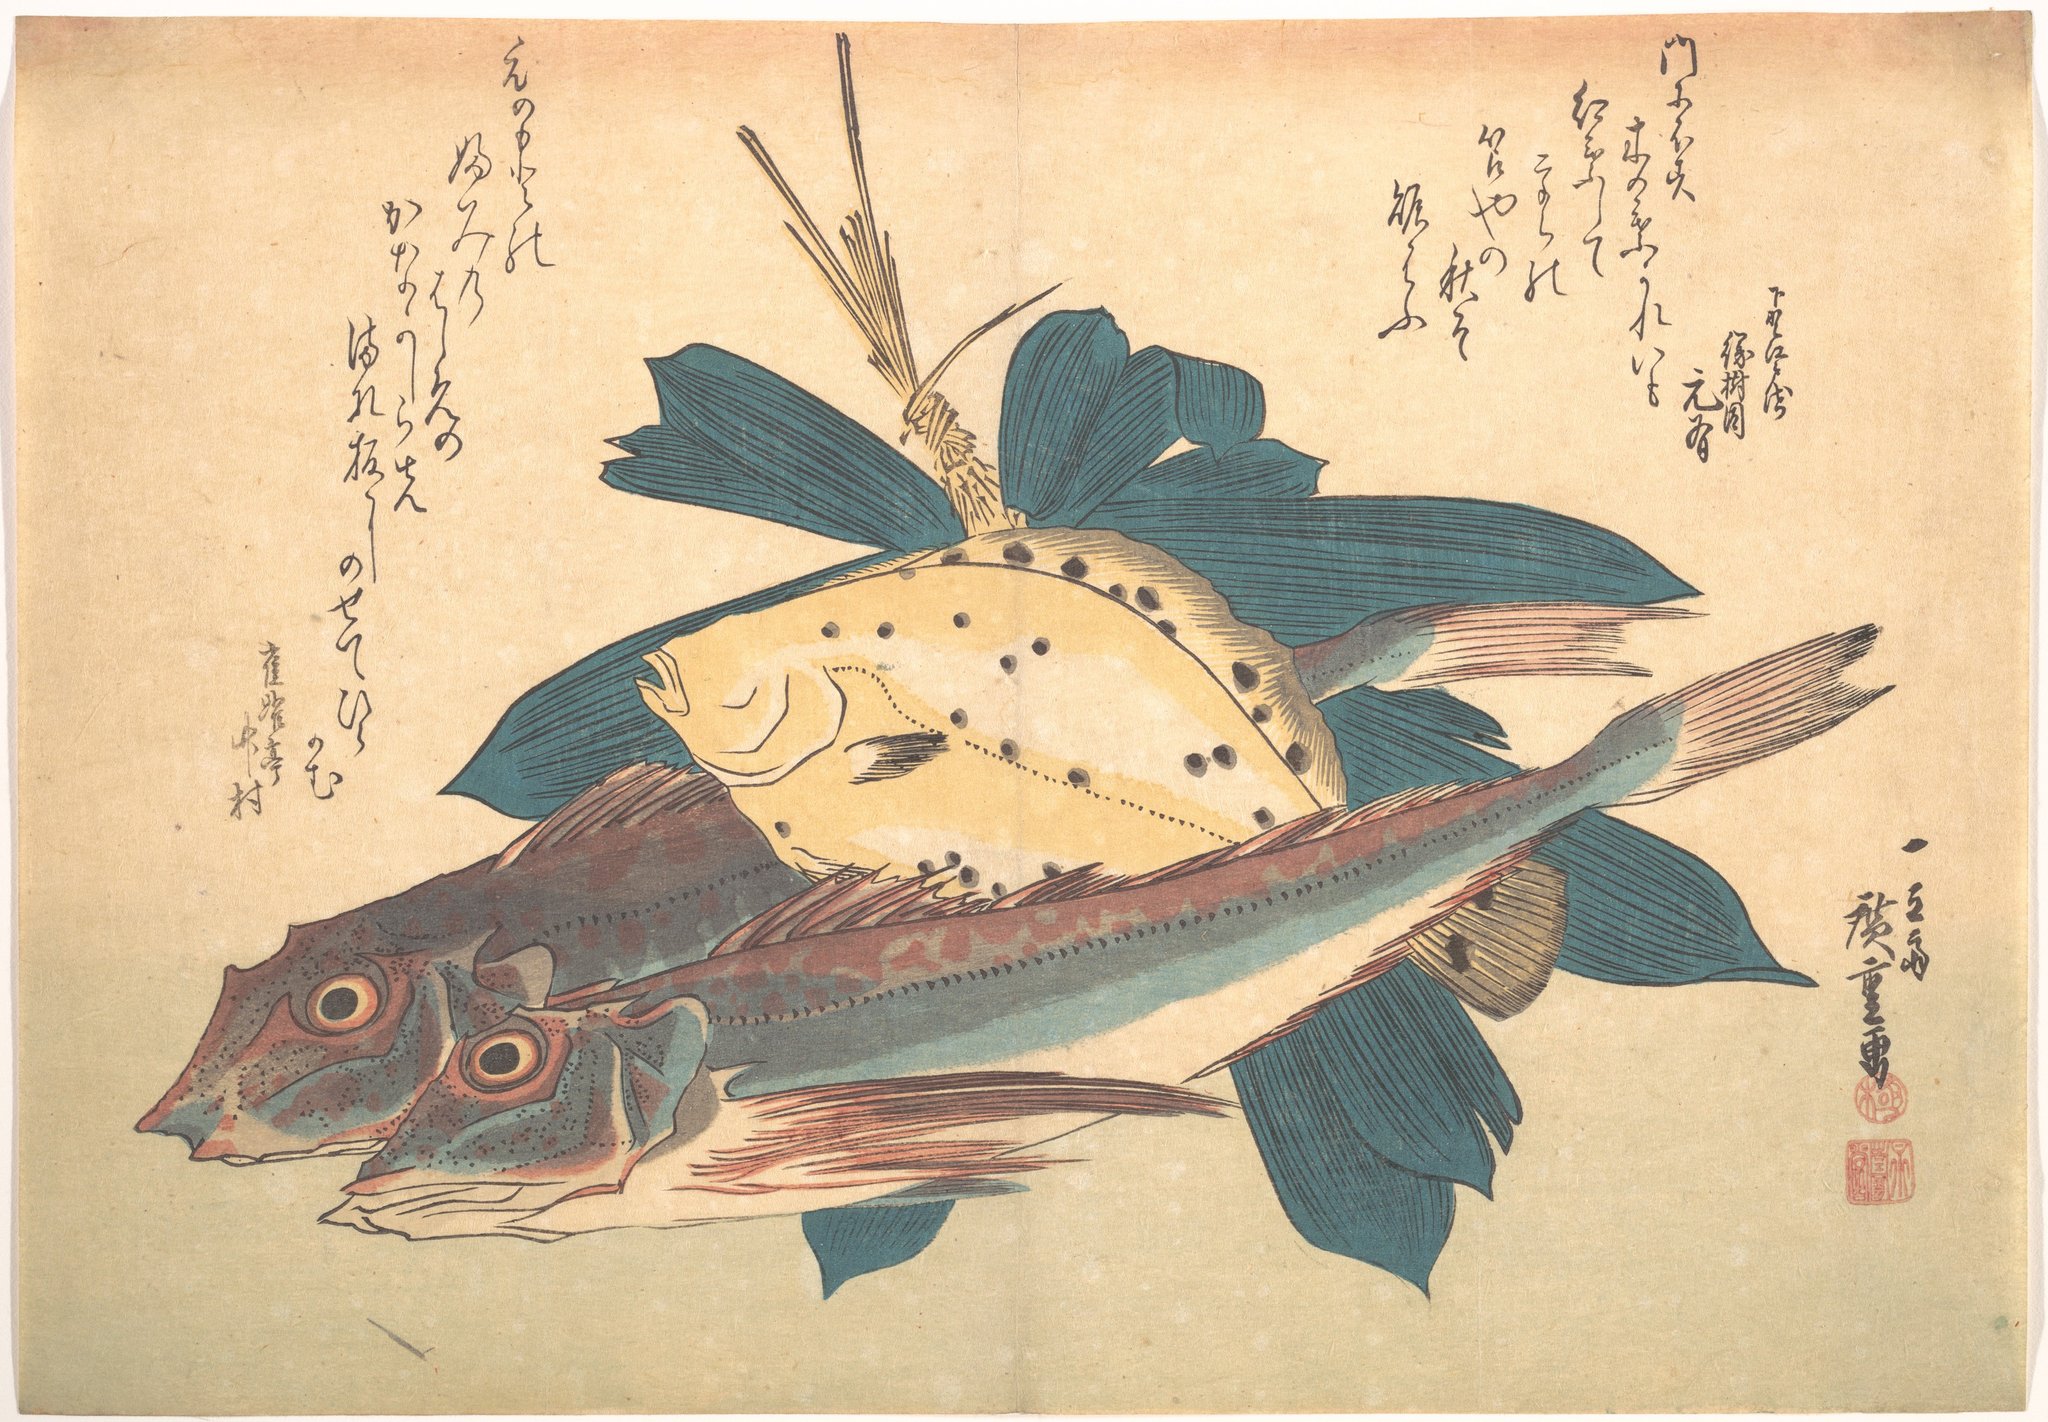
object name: woodblock print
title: Kanagashira and Karei Fish, from the series Uozukushi (Every Variety of Fish)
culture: japanese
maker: utagawa hiroshige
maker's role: artist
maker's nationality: japanese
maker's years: 1797-1858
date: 1830-1839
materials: ink, paper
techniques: woodblock print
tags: fish